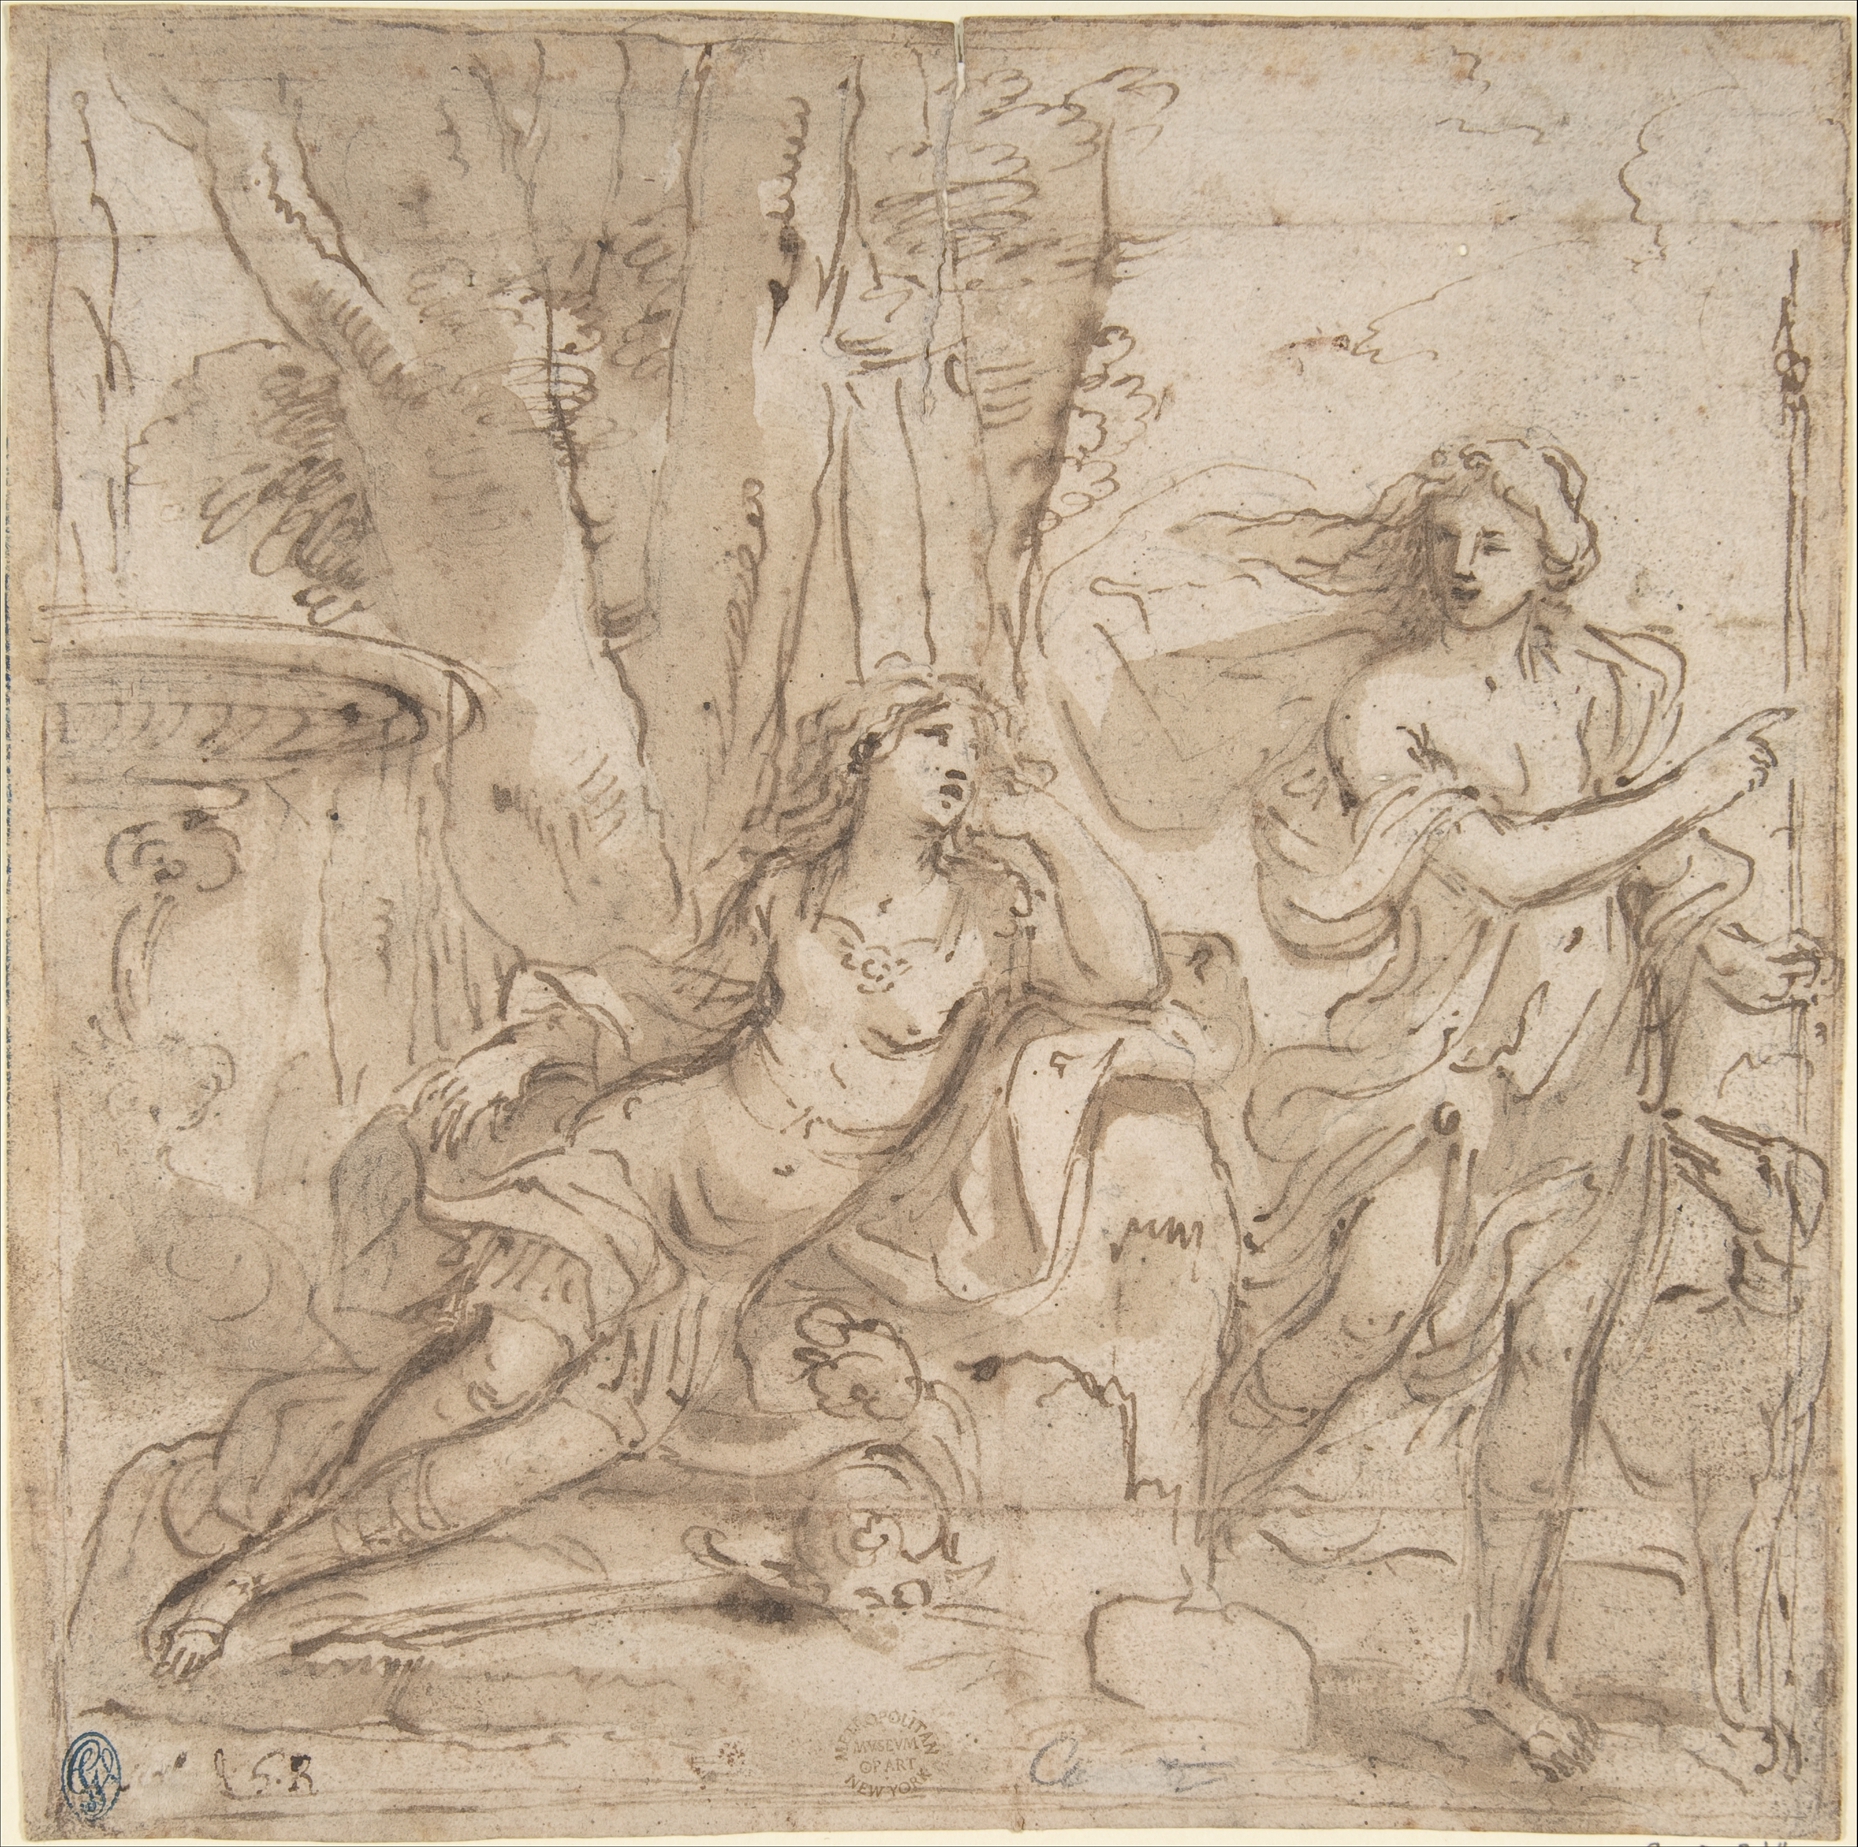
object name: drawing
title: Venus and Adonis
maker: anonymous, italian, roman-bolognese, 17th century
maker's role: artist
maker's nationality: italian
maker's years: 1600-1700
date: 1601-1700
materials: chalk, ink, paper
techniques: brush, pen, wash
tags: adonis,venus